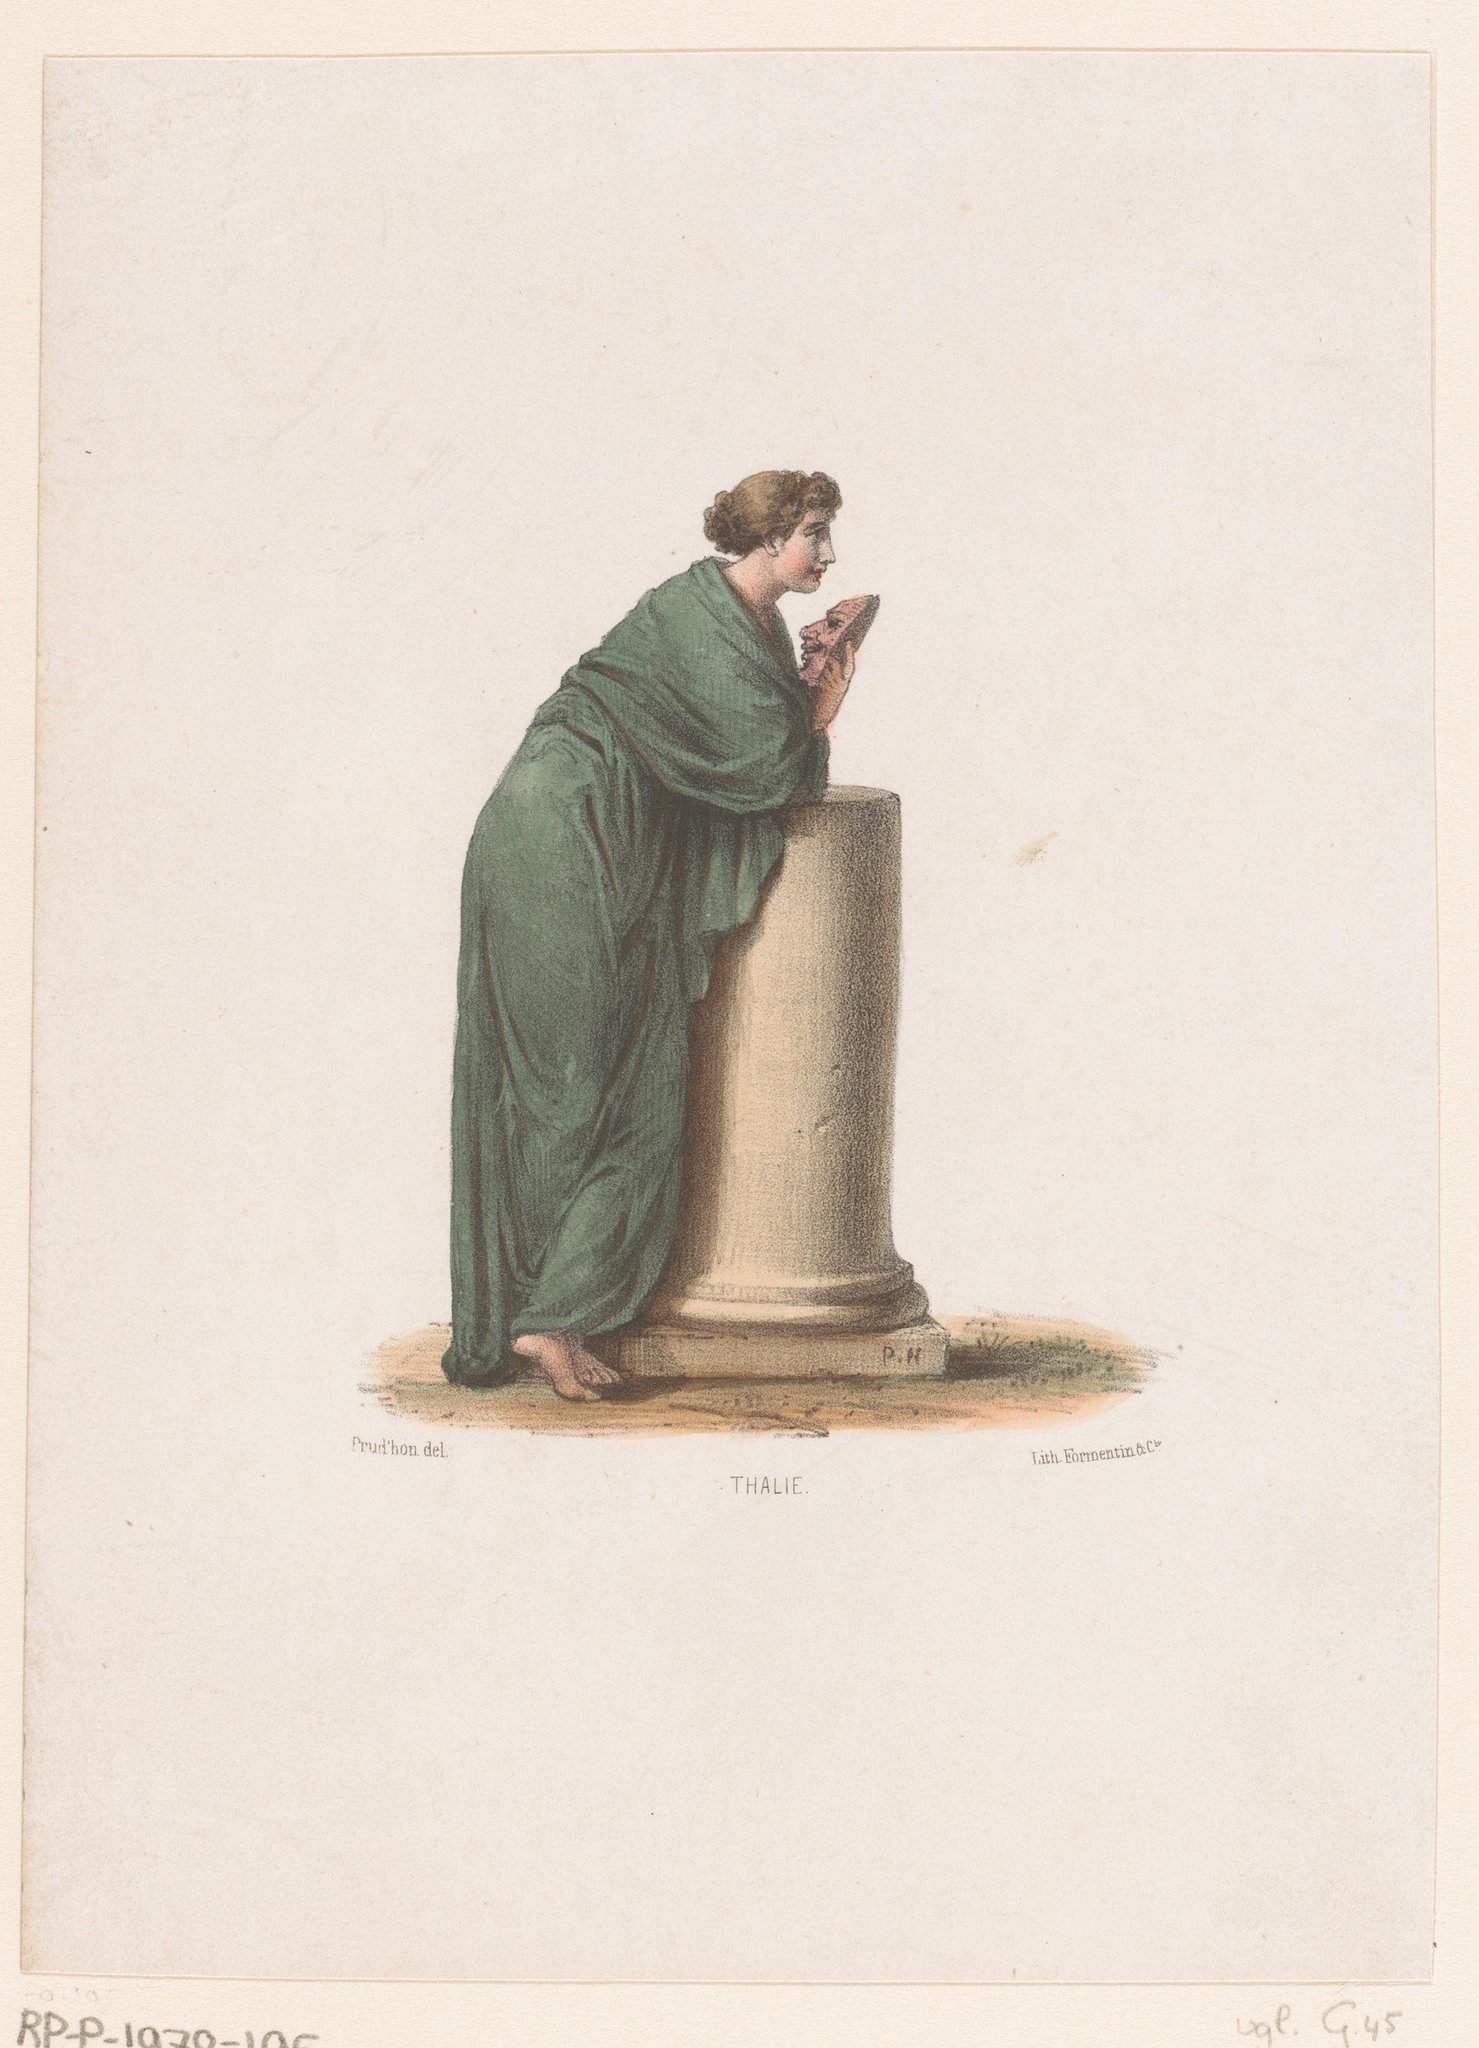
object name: print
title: Thalia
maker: Anonymous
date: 1824-1856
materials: paper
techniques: hand coloring, lithograph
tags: thalia (one of the muses); 'talia' (ripa)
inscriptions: collector's mark: Lugt 2228a, collector's mark: Lugt 2760